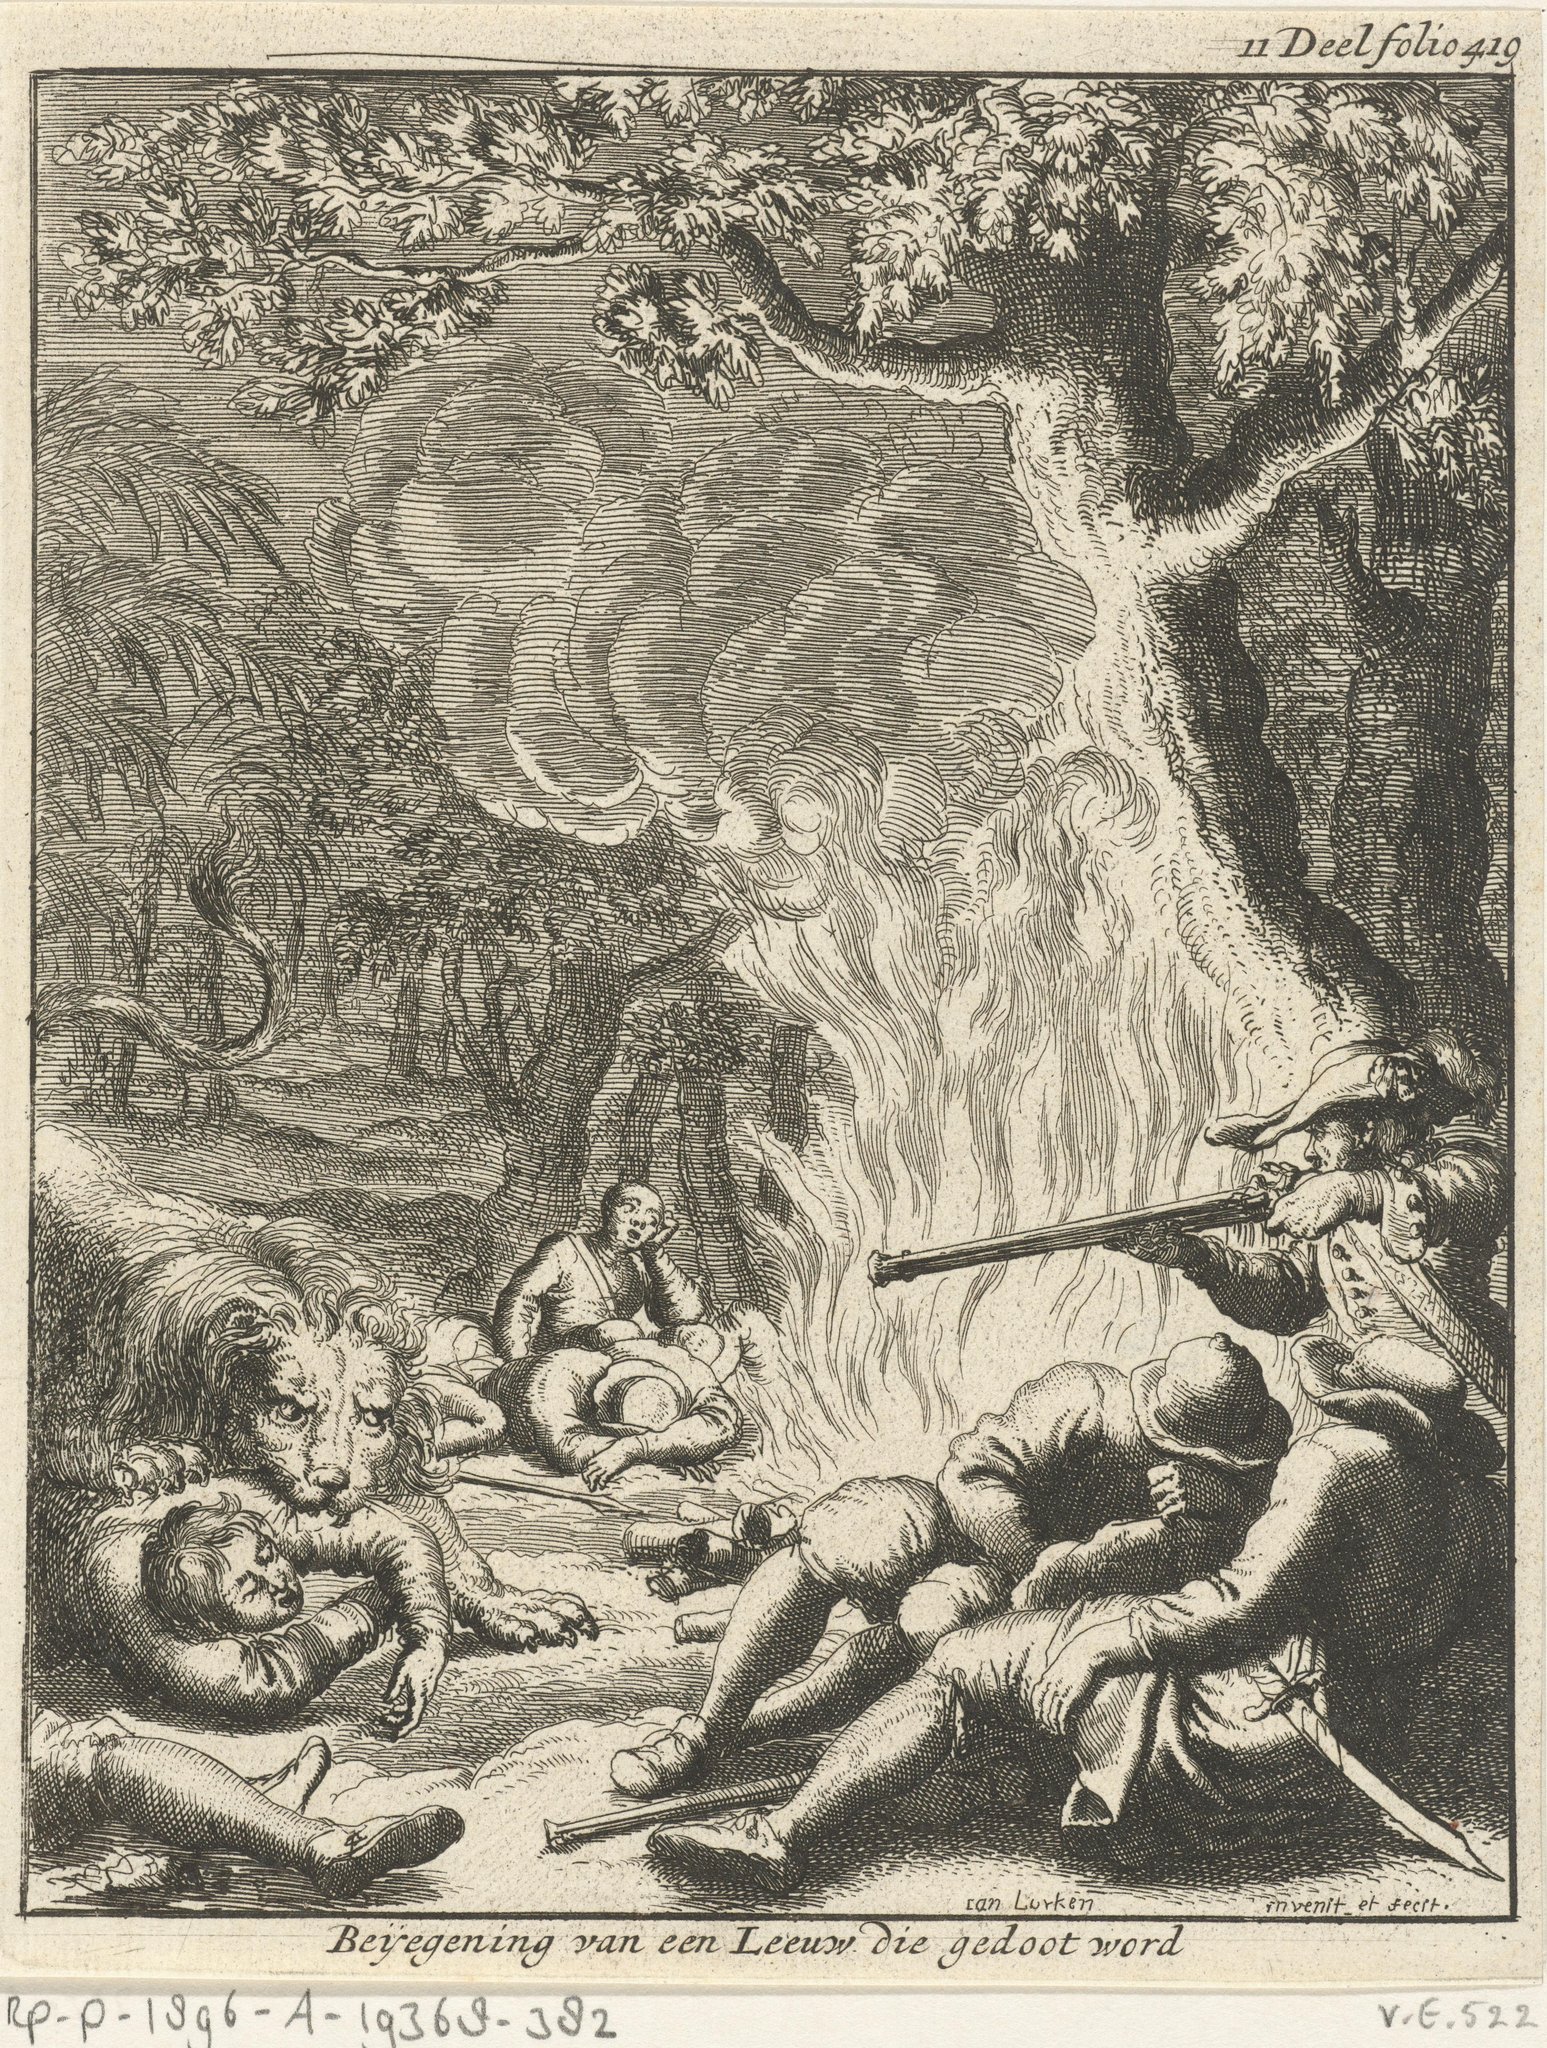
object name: book illustration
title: Beijegening van een Leeuw die gedoot word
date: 1682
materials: paper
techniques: etching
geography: amsterdam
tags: beasts of prey, predatory animals: lion (+ animal(s) being hit, shot, caught), animal killing man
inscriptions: collector's mark: Lugt 2228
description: Illustratie opgenomen in: Tavernier, Jean Baptiste. De Zes Reizen, 3 delen. Amsterdam: weduwe Joannes van Someren, 1682, dl. 2.